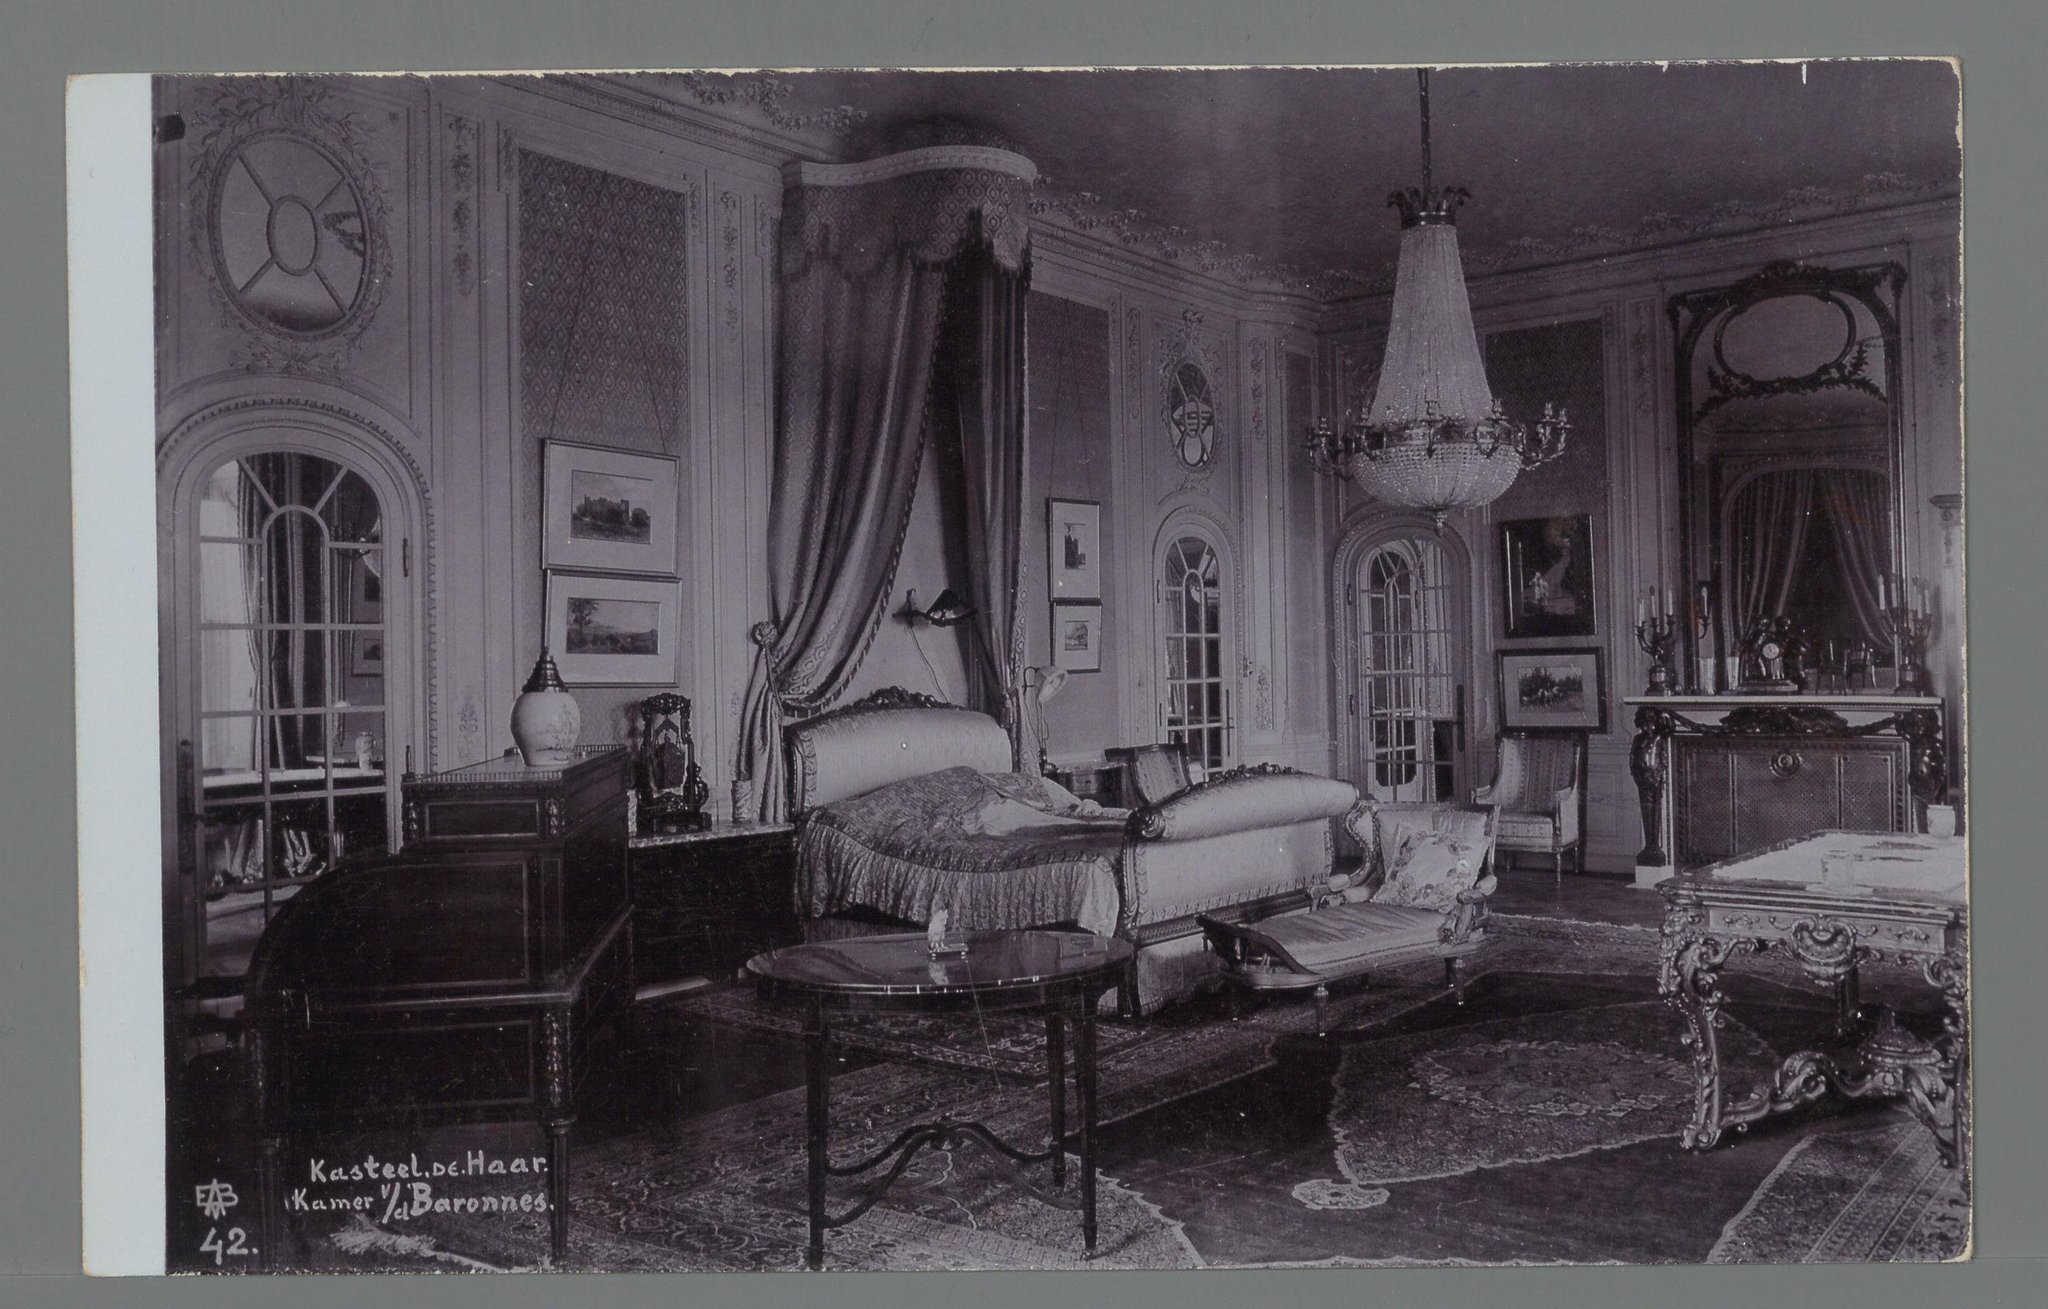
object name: ansichtkaart, prentbriefkaart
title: Kasteel de Haar. Kamer v/d baronnes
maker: Anonymous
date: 1900-1930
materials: paper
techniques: collodion silver print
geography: haarzuilens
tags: castle, interior of the house, bed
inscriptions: monogram: ‘M.R.A. U.’, monogram: ‘EBvA’